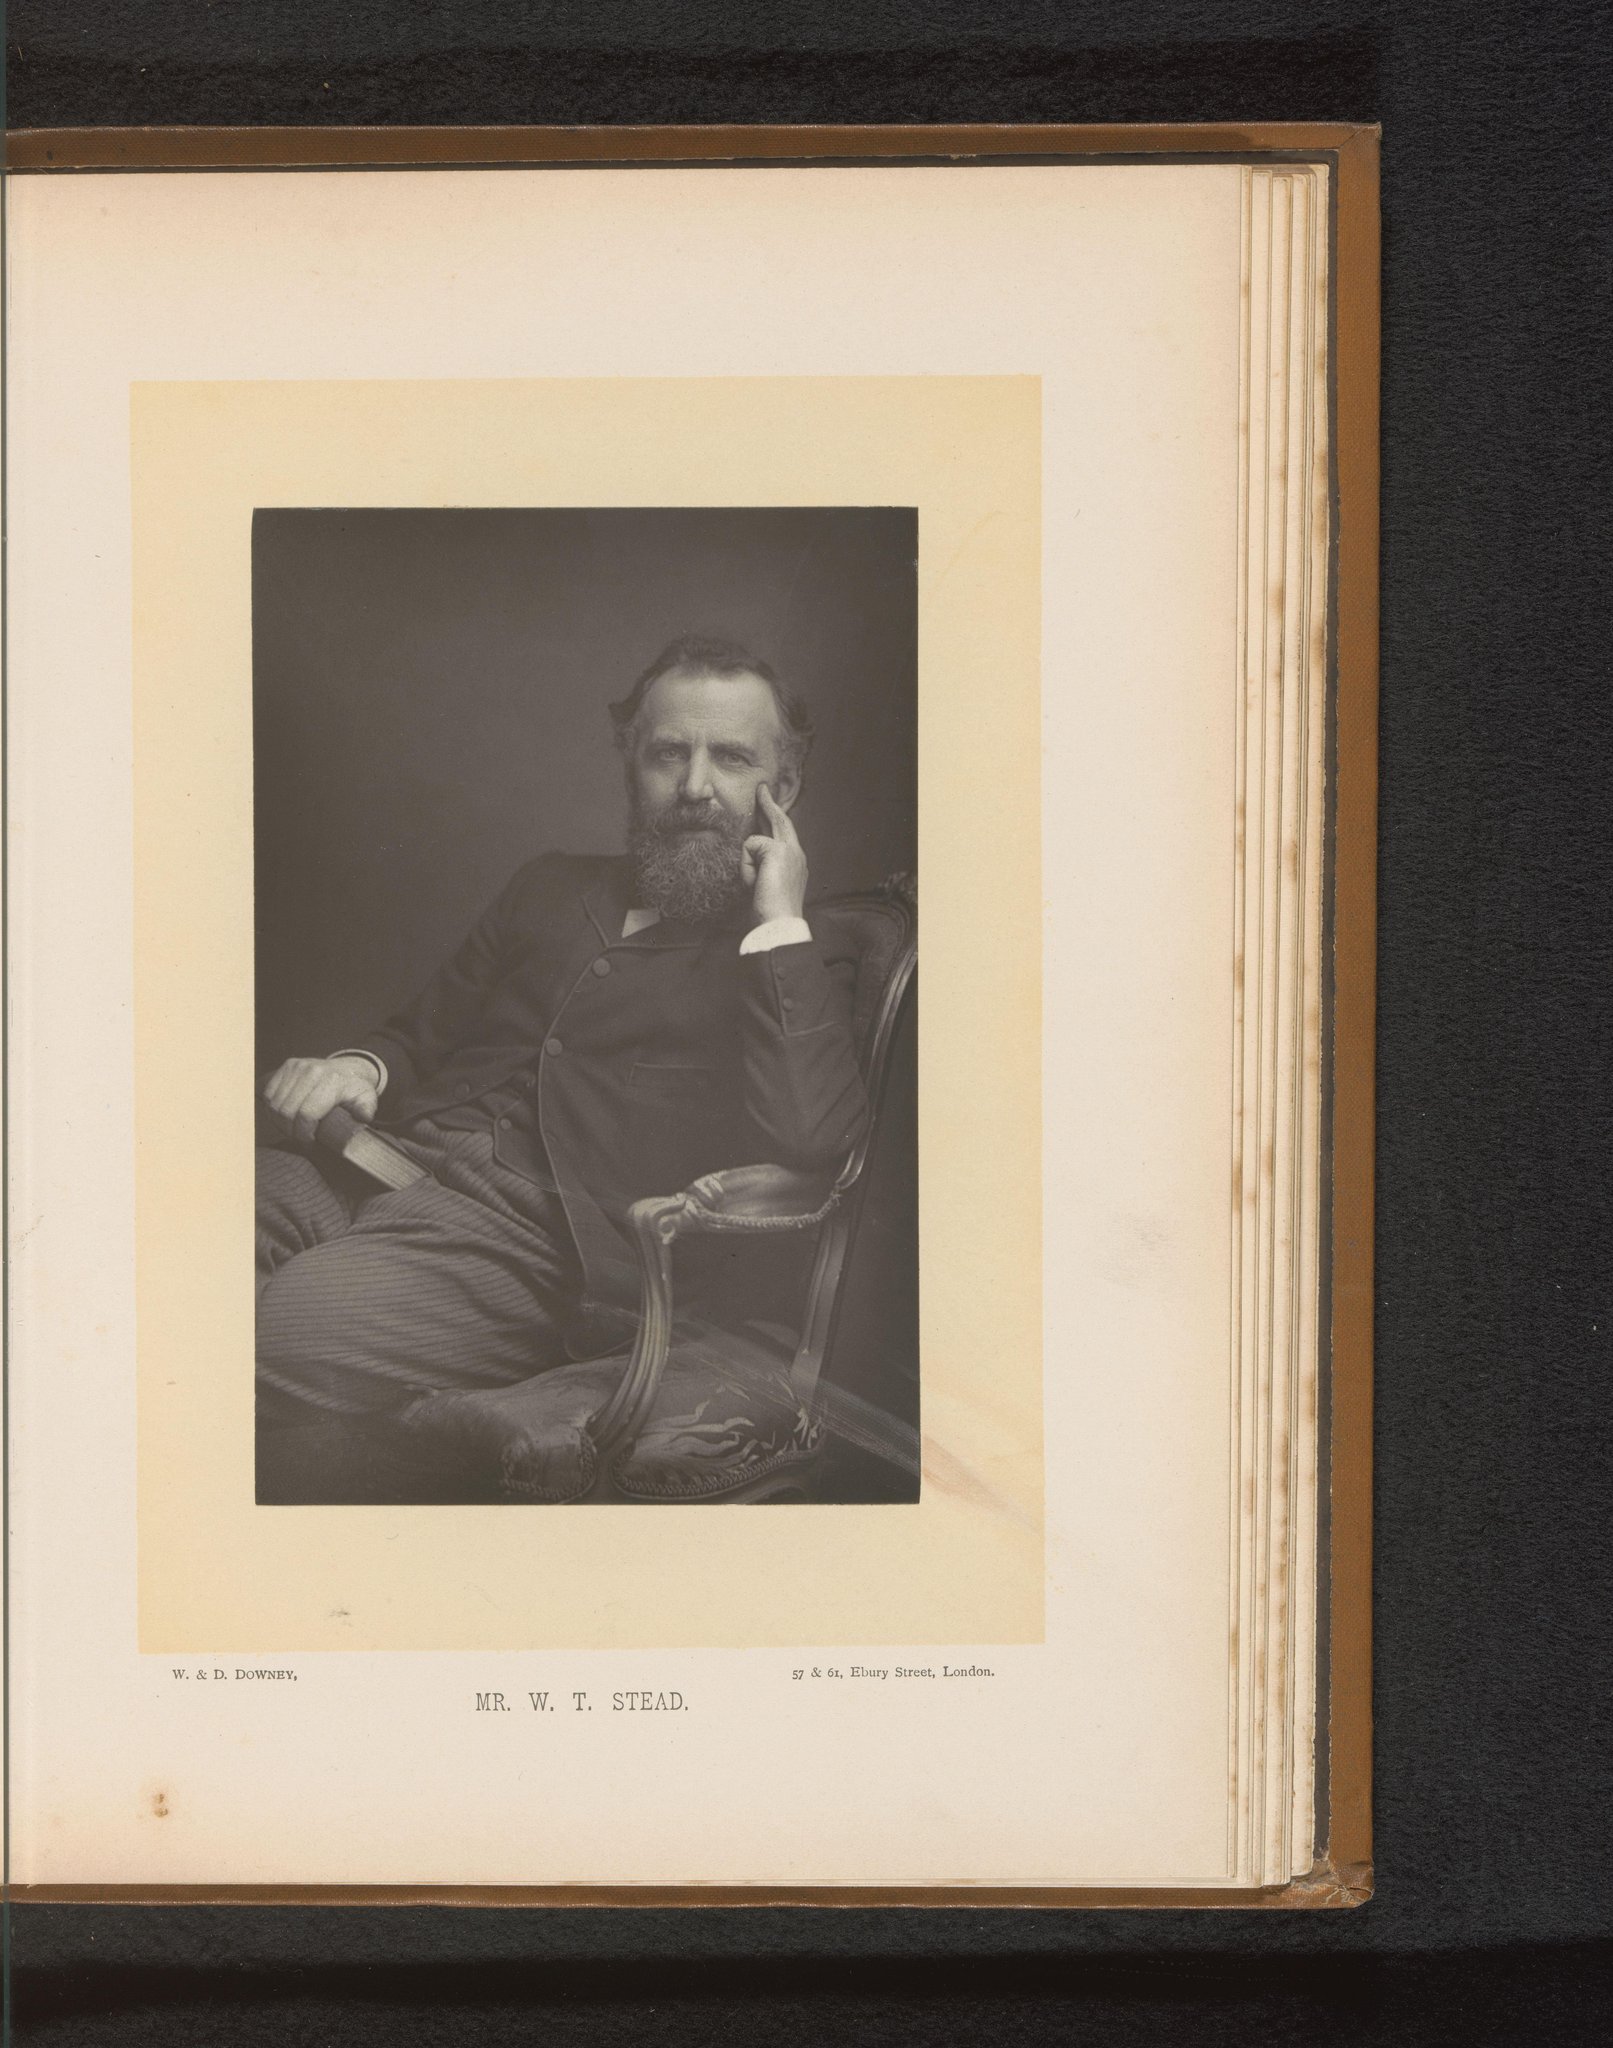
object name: page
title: Mr. W.T. Stead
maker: Anonymous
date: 1883-1893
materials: paper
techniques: woodburytype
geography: london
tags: william thomas stead, journalist, reporter, publishing, publisher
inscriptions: inscription: ‘57 & 61, Elbury Street, London.’